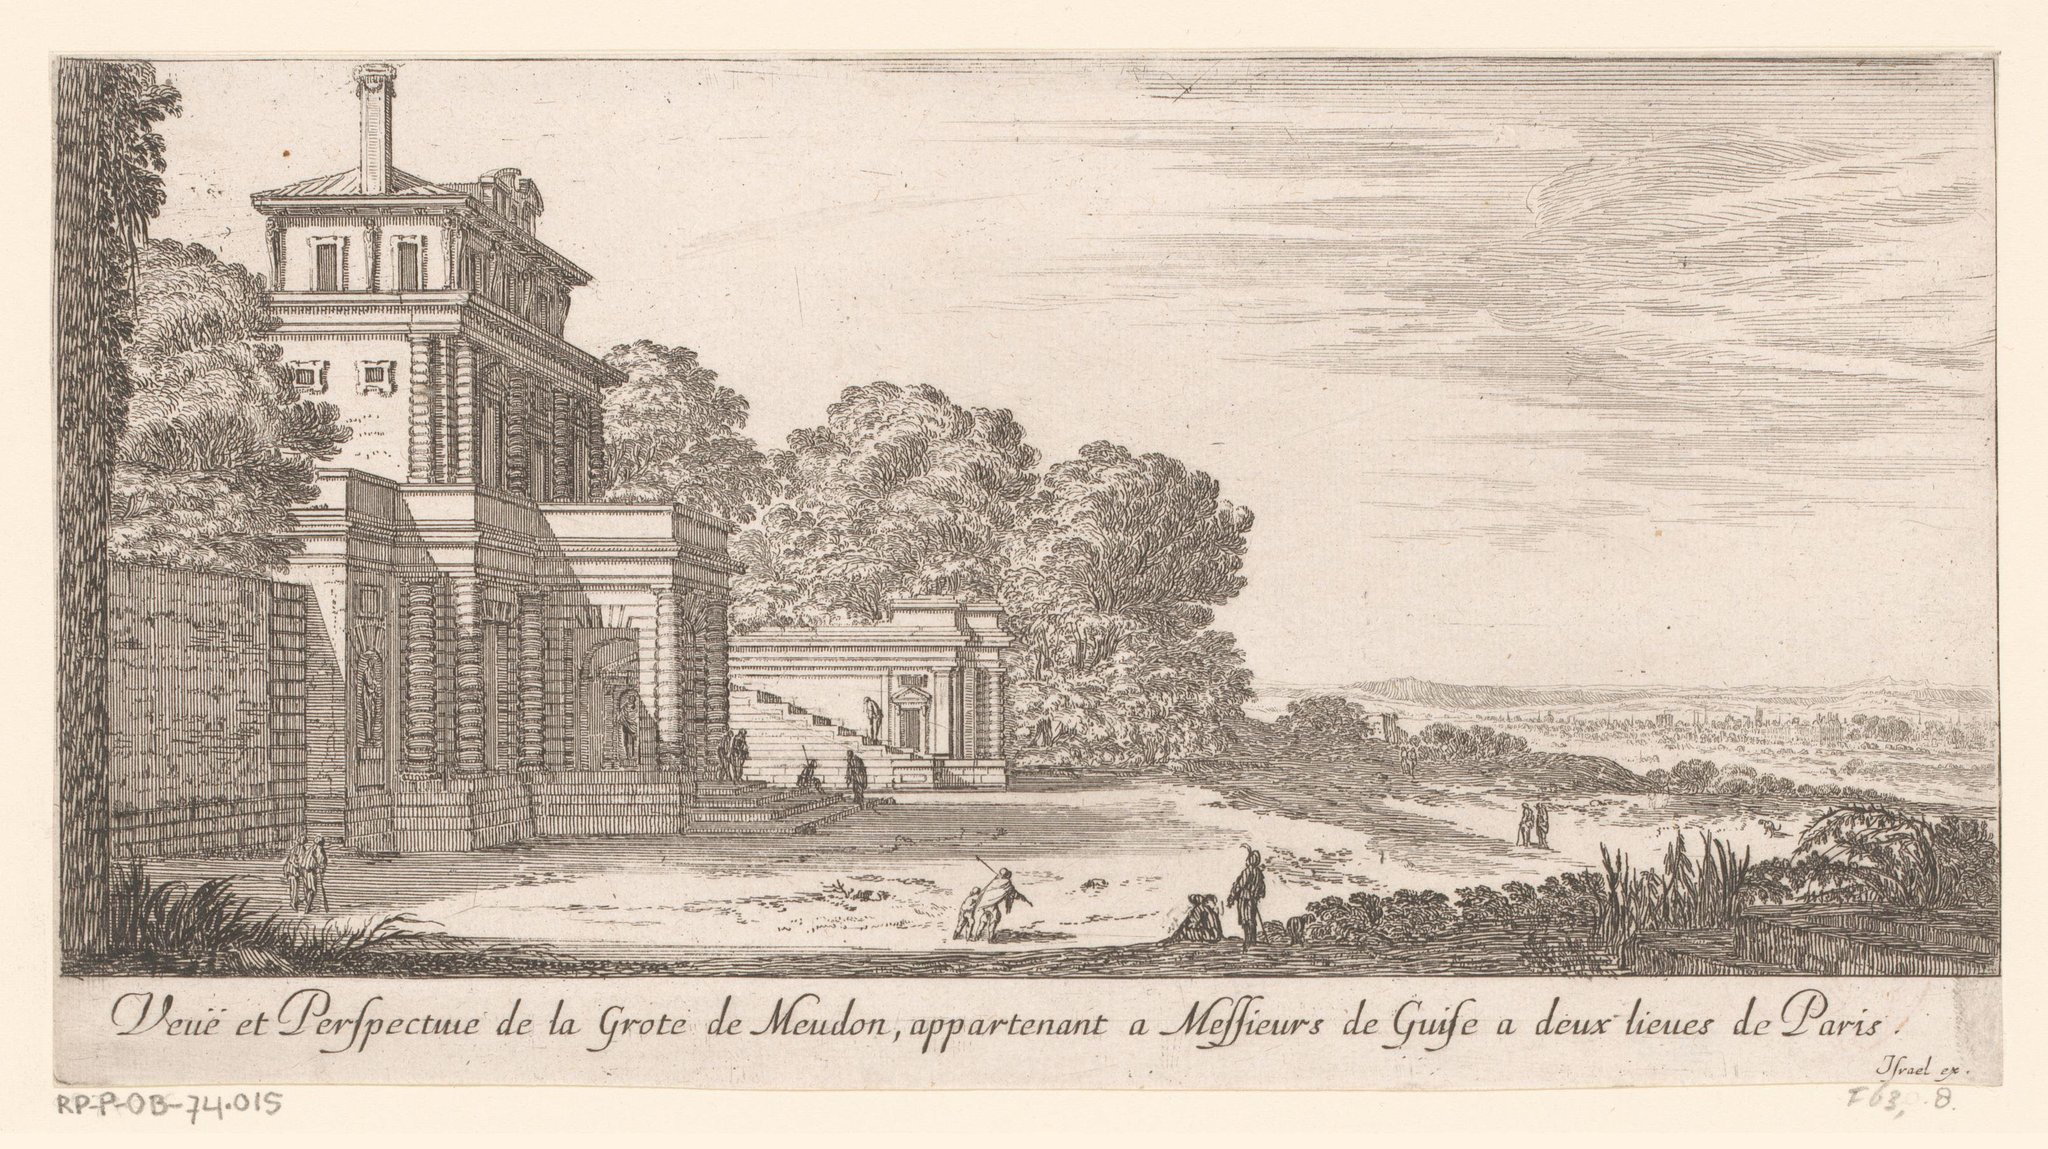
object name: print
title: Hommage aan de rijkdom die de rivieren brengen aan Parijs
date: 1654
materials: paper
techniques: engraving, etching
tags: landscape with tower or castle, artificial grotto in garden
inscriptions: collector's mark: Lugt 240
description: Prent maakt deel uit van een ongenummerde serie van 21 prenten.